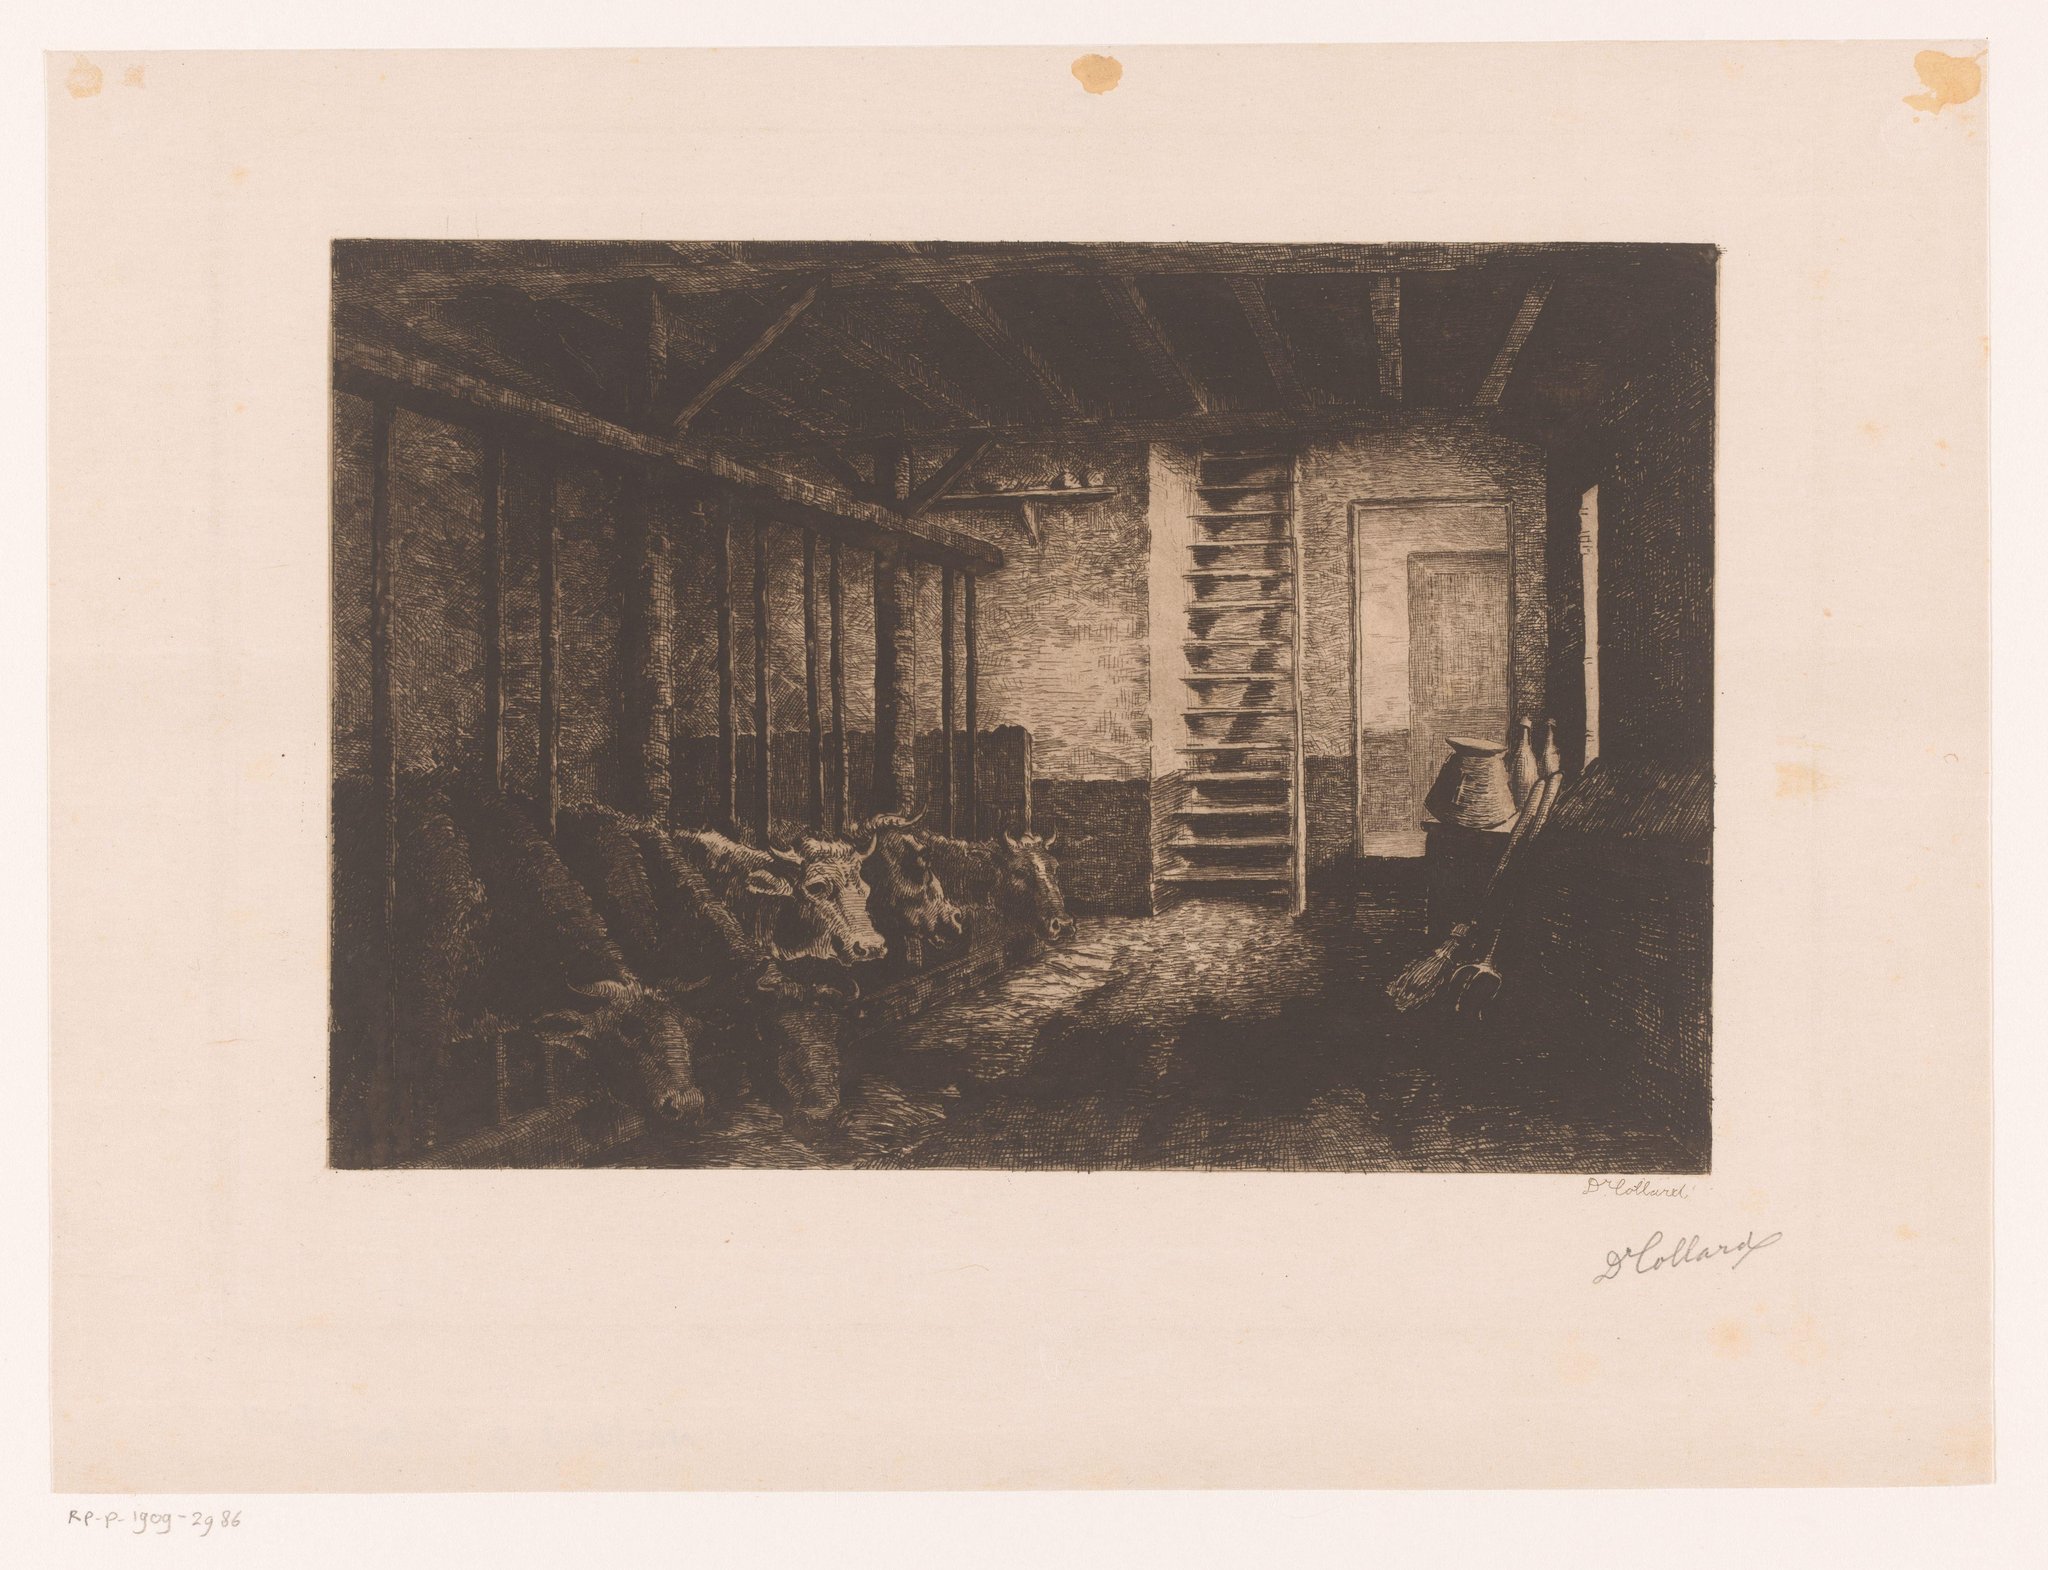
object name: print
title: Koeienstal met trap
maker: armand collard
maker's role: print maker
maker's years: 1838-1910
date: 1848-1909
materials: paper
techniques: etching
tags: barn, cow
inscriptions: collector's mark: Lugt 2228, mark: ‘Antwerpsche Etsers 1880’